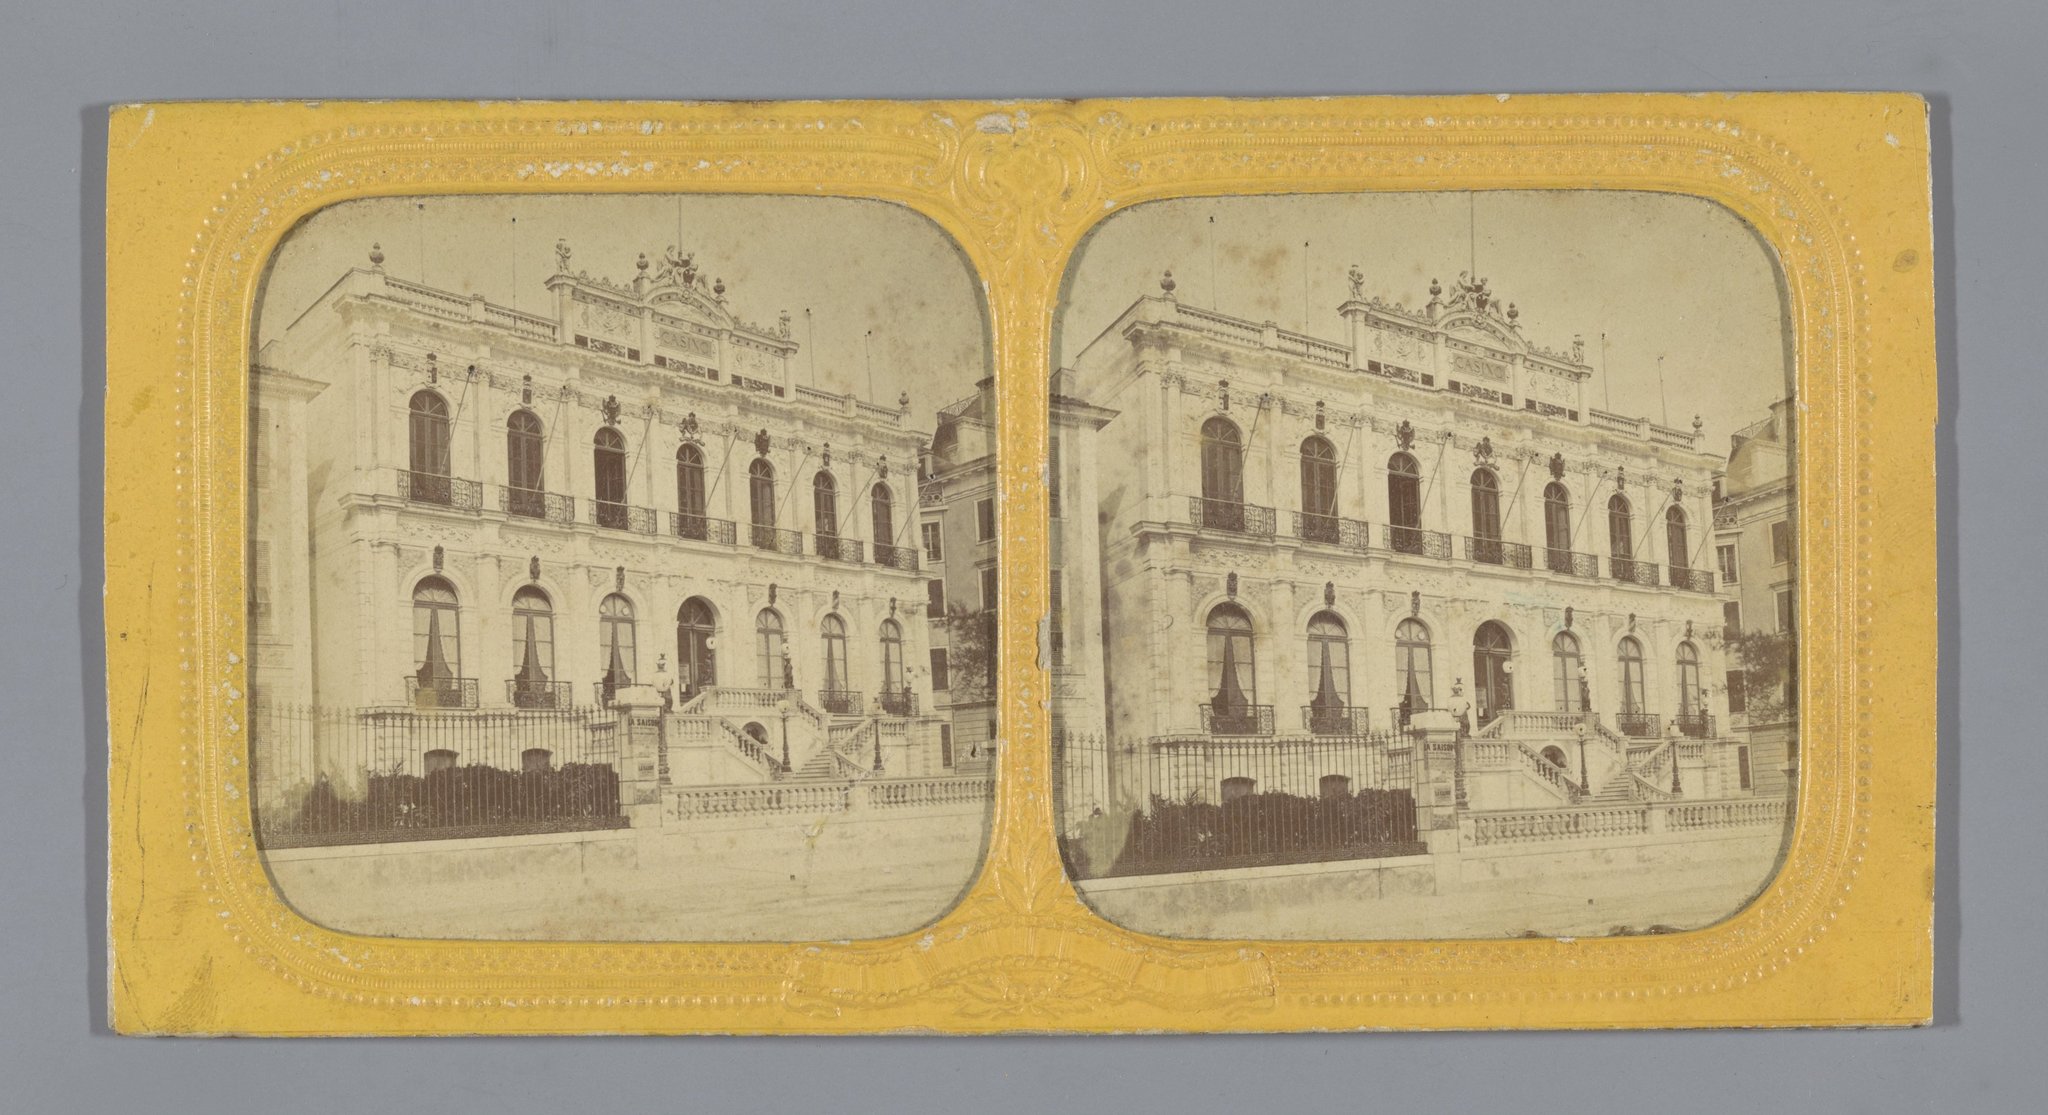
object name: tissue stereograph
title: Casino, Nice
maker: Anonymous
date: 1855-1875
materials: cardboard, paper, photographic support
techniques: albumen print, hand coloring, perforating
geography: nice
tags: façade (of house or building), casino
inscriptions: inscription: ‘st/ 75’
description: Casino in Nice aan de Promenade des Anglais.